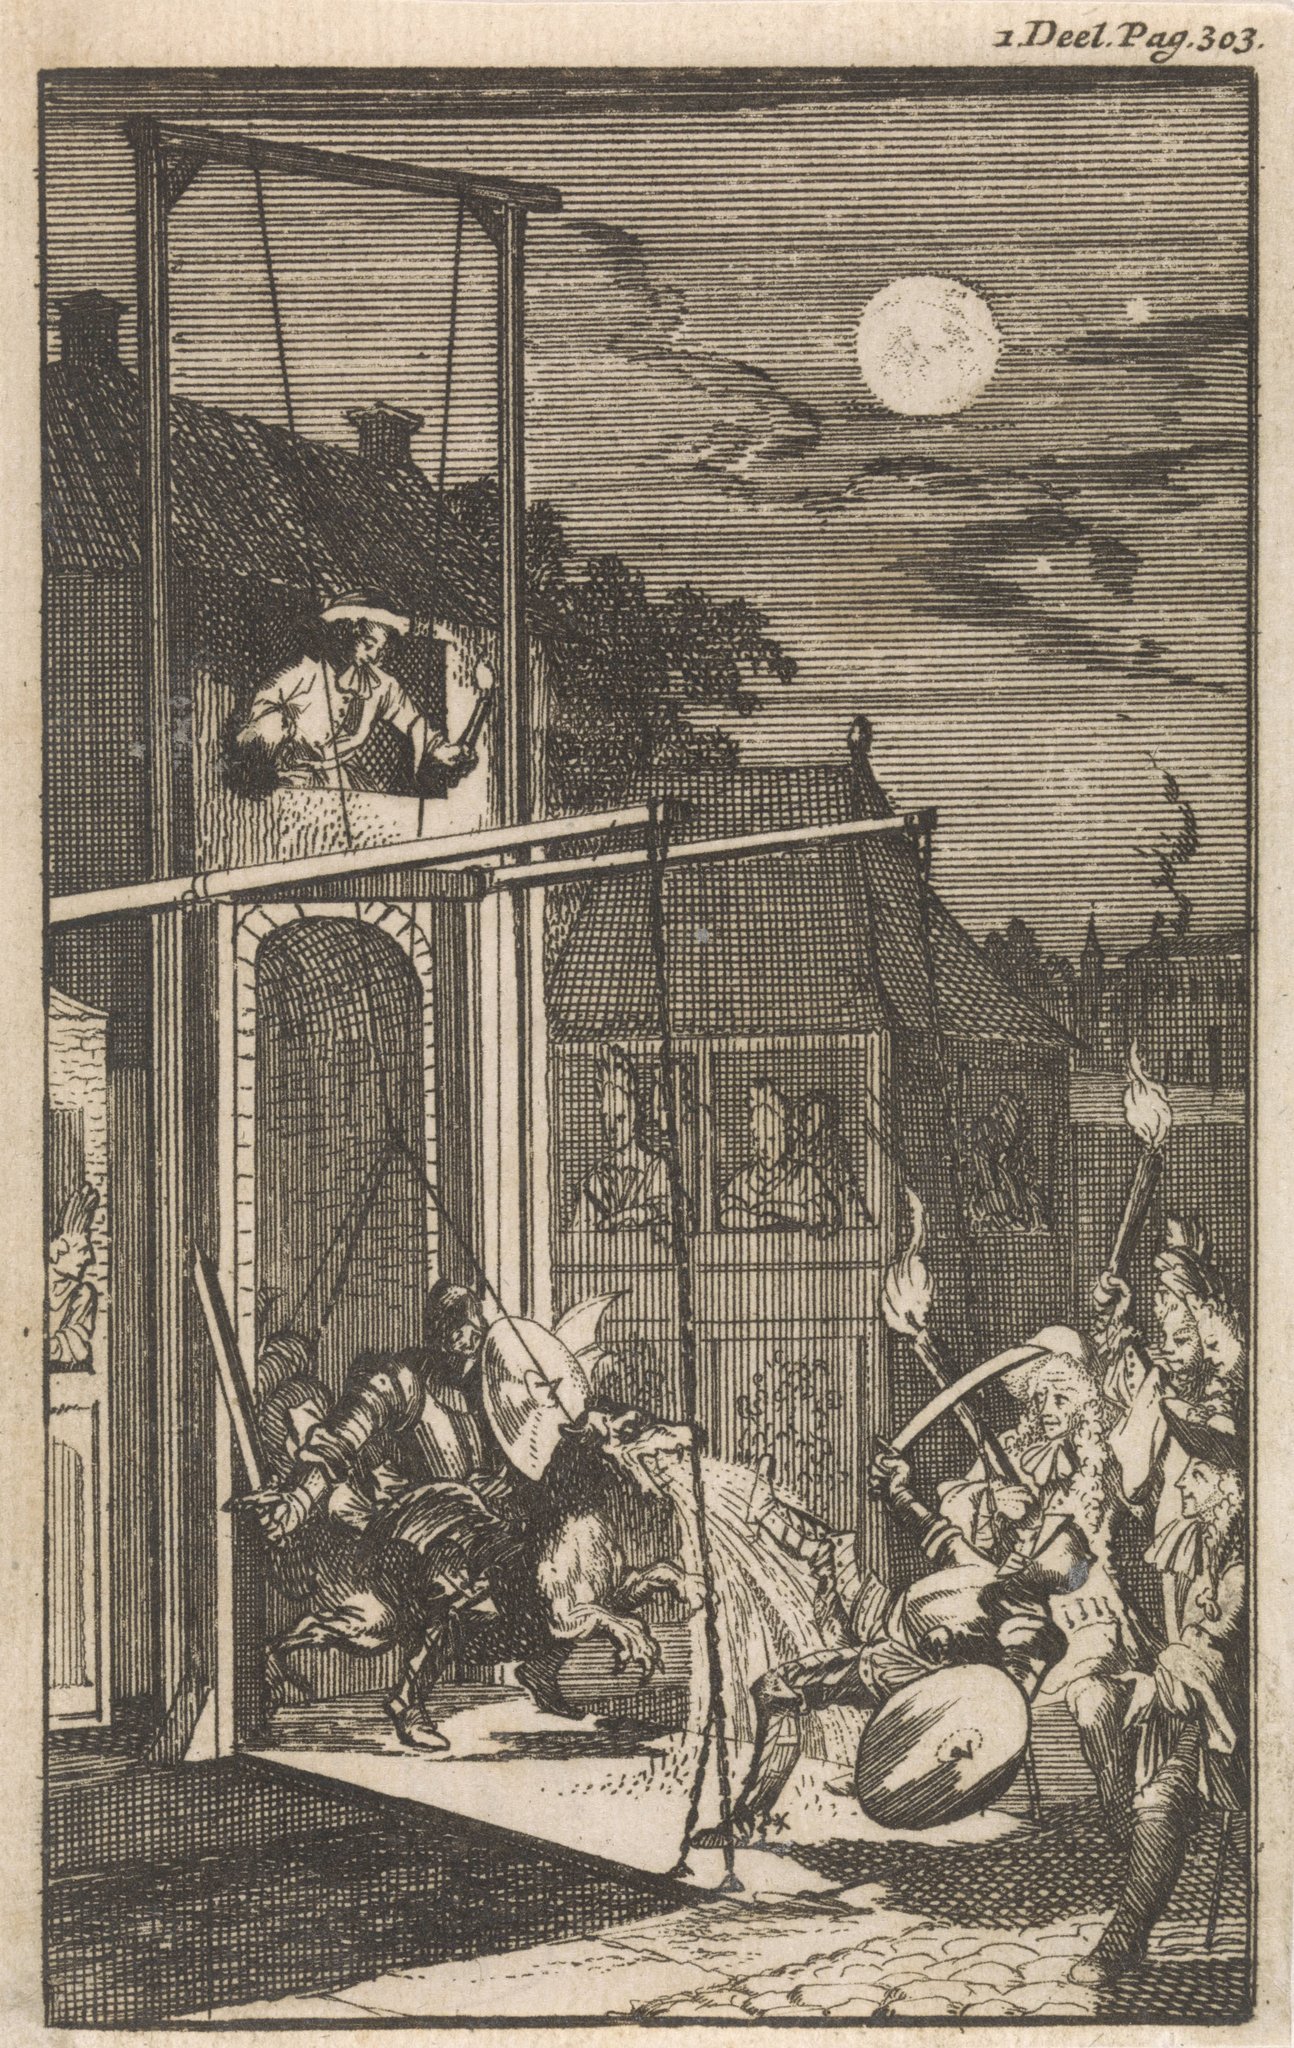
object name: print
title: Strijd van Don Clarazel met de pop, die de reus Dardanel op de vuurspuwende draak voorstelt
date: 1697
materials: paper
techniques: etching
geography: amsterdam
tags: battle, fighting in general, dragon, knight, giants, colossi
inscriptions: collector's mark: Lugt 2228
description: Illustratie uit: Verdier, Gilbert Saulnier du (vert. Heinsius, Nicolaas junior). Don Clarazel de Gontarnos, ofte den buiten-spoorigen dolenden ridder, 2 delen. Amsterdam: Johannes Broersz en Nathanael Holbeex, 1697, dl. 1.